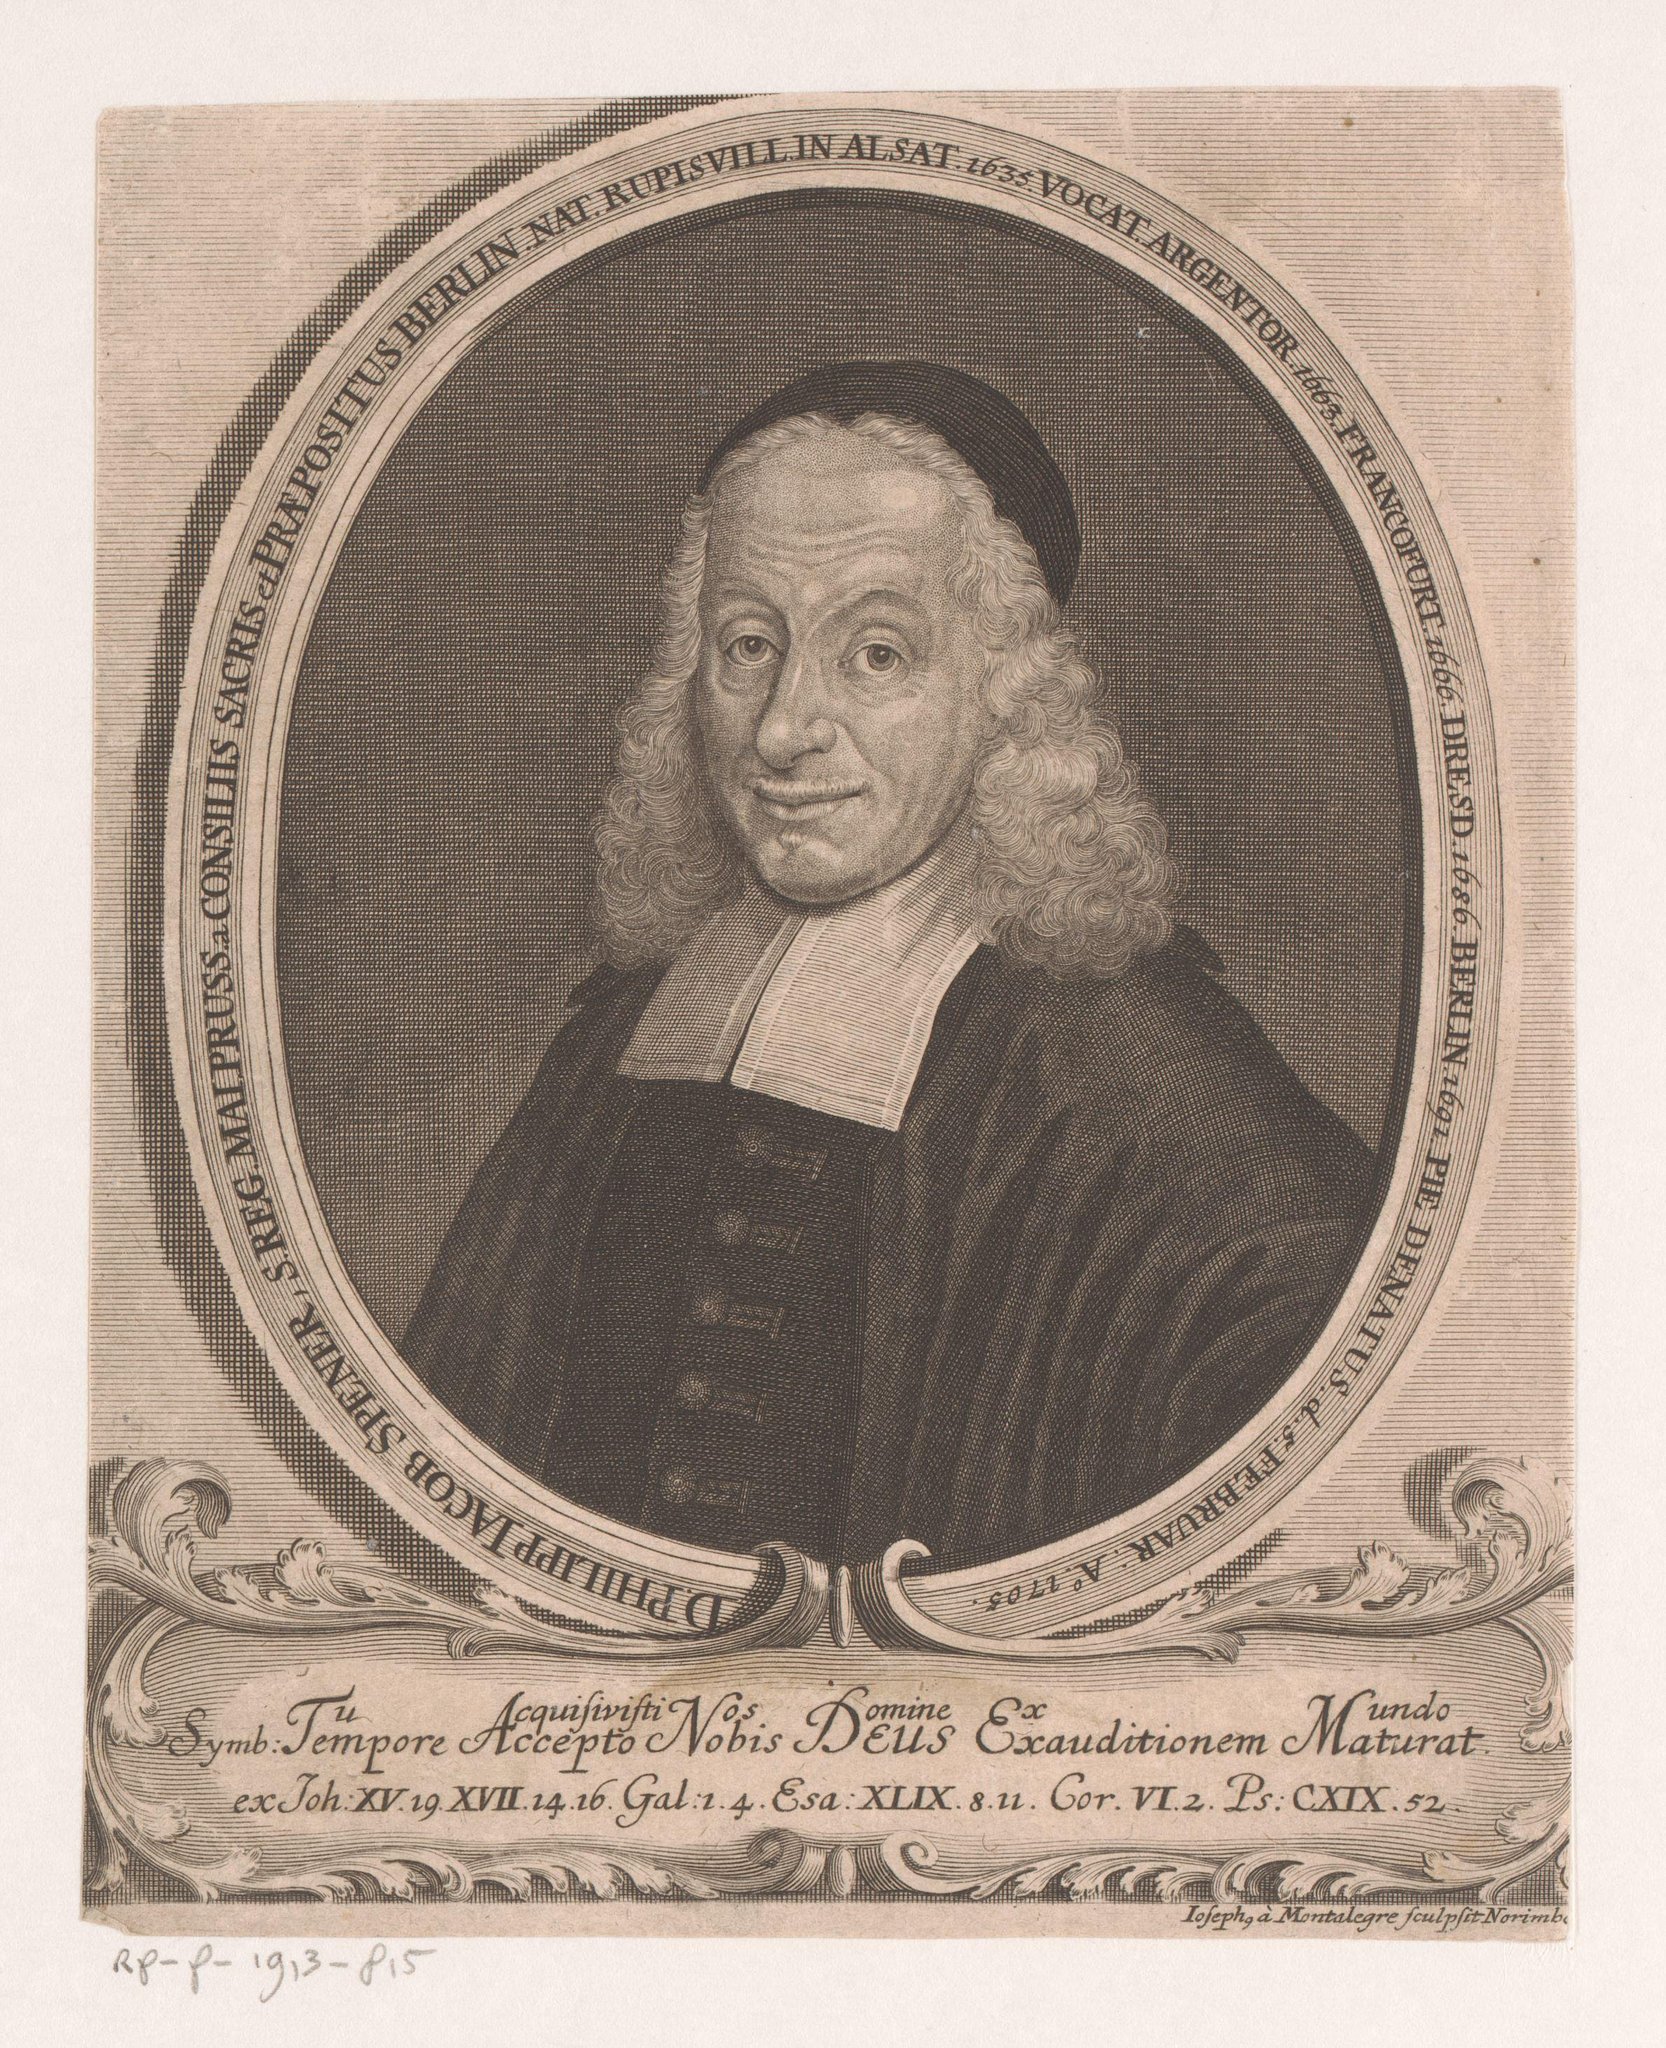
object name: print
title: Portret van Philipp Jacob Spener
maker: joseph de montalegre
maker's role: print maker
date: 1700-1799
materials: paper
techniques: engraving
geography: nuremberg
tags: philipp jacob spener, theologian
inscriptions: collector's mark: Lugt 2228